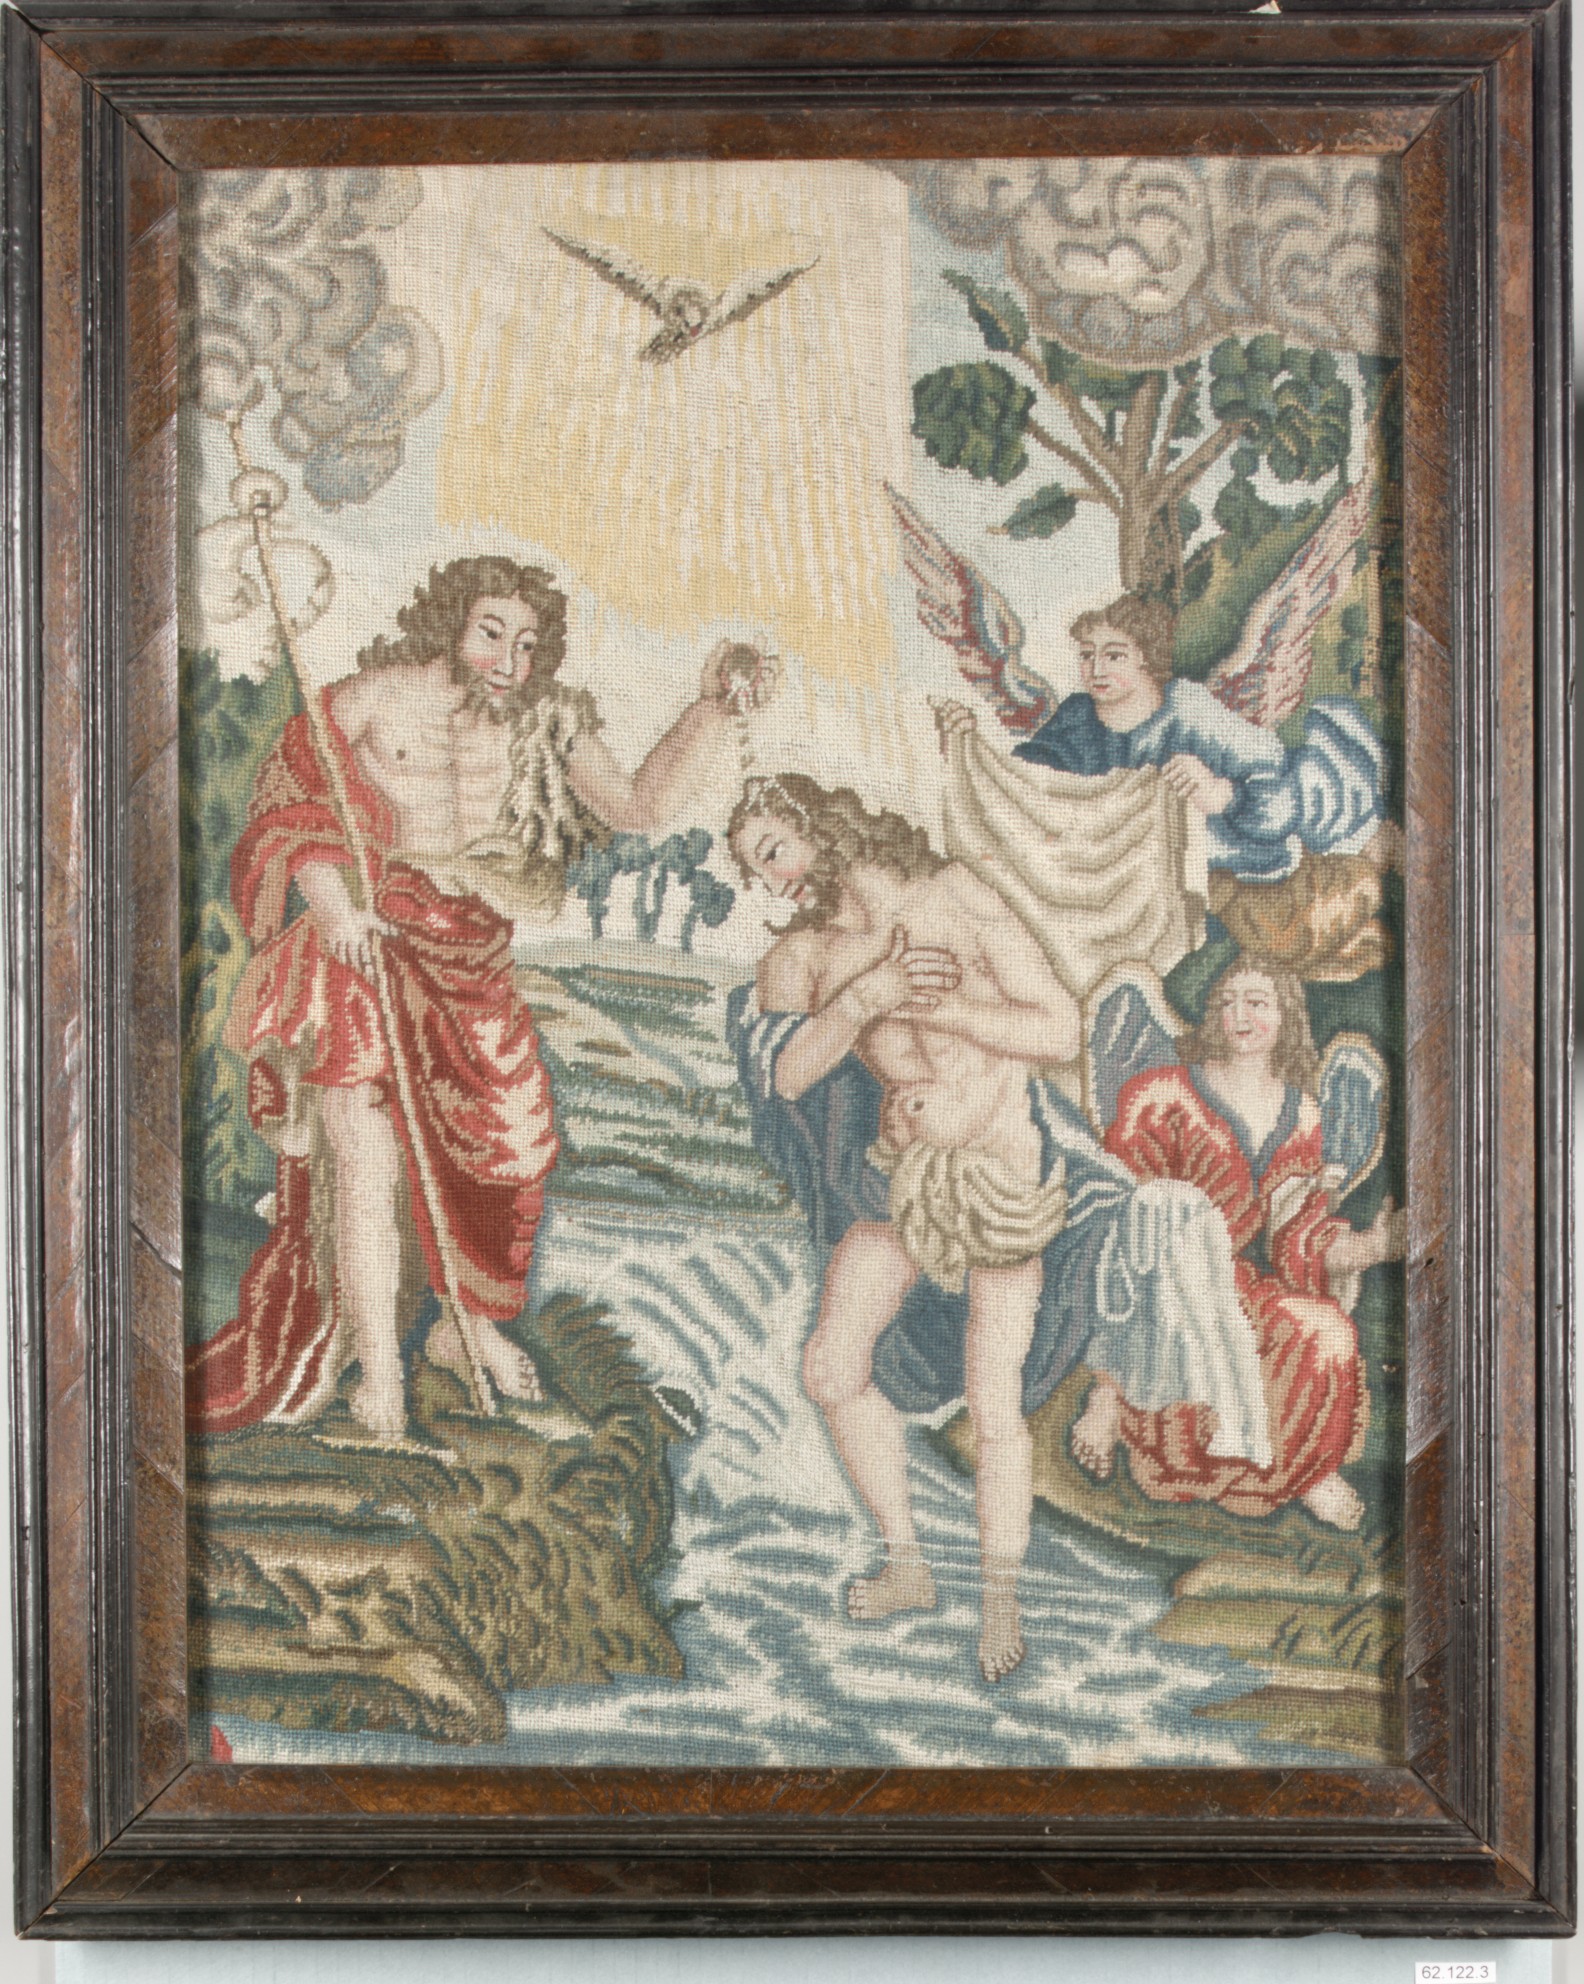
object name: embroidered picture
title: Baptism of Christ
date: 1801-1900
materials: silk, wool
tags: rivers,trees,angels,christ,baptism of christ